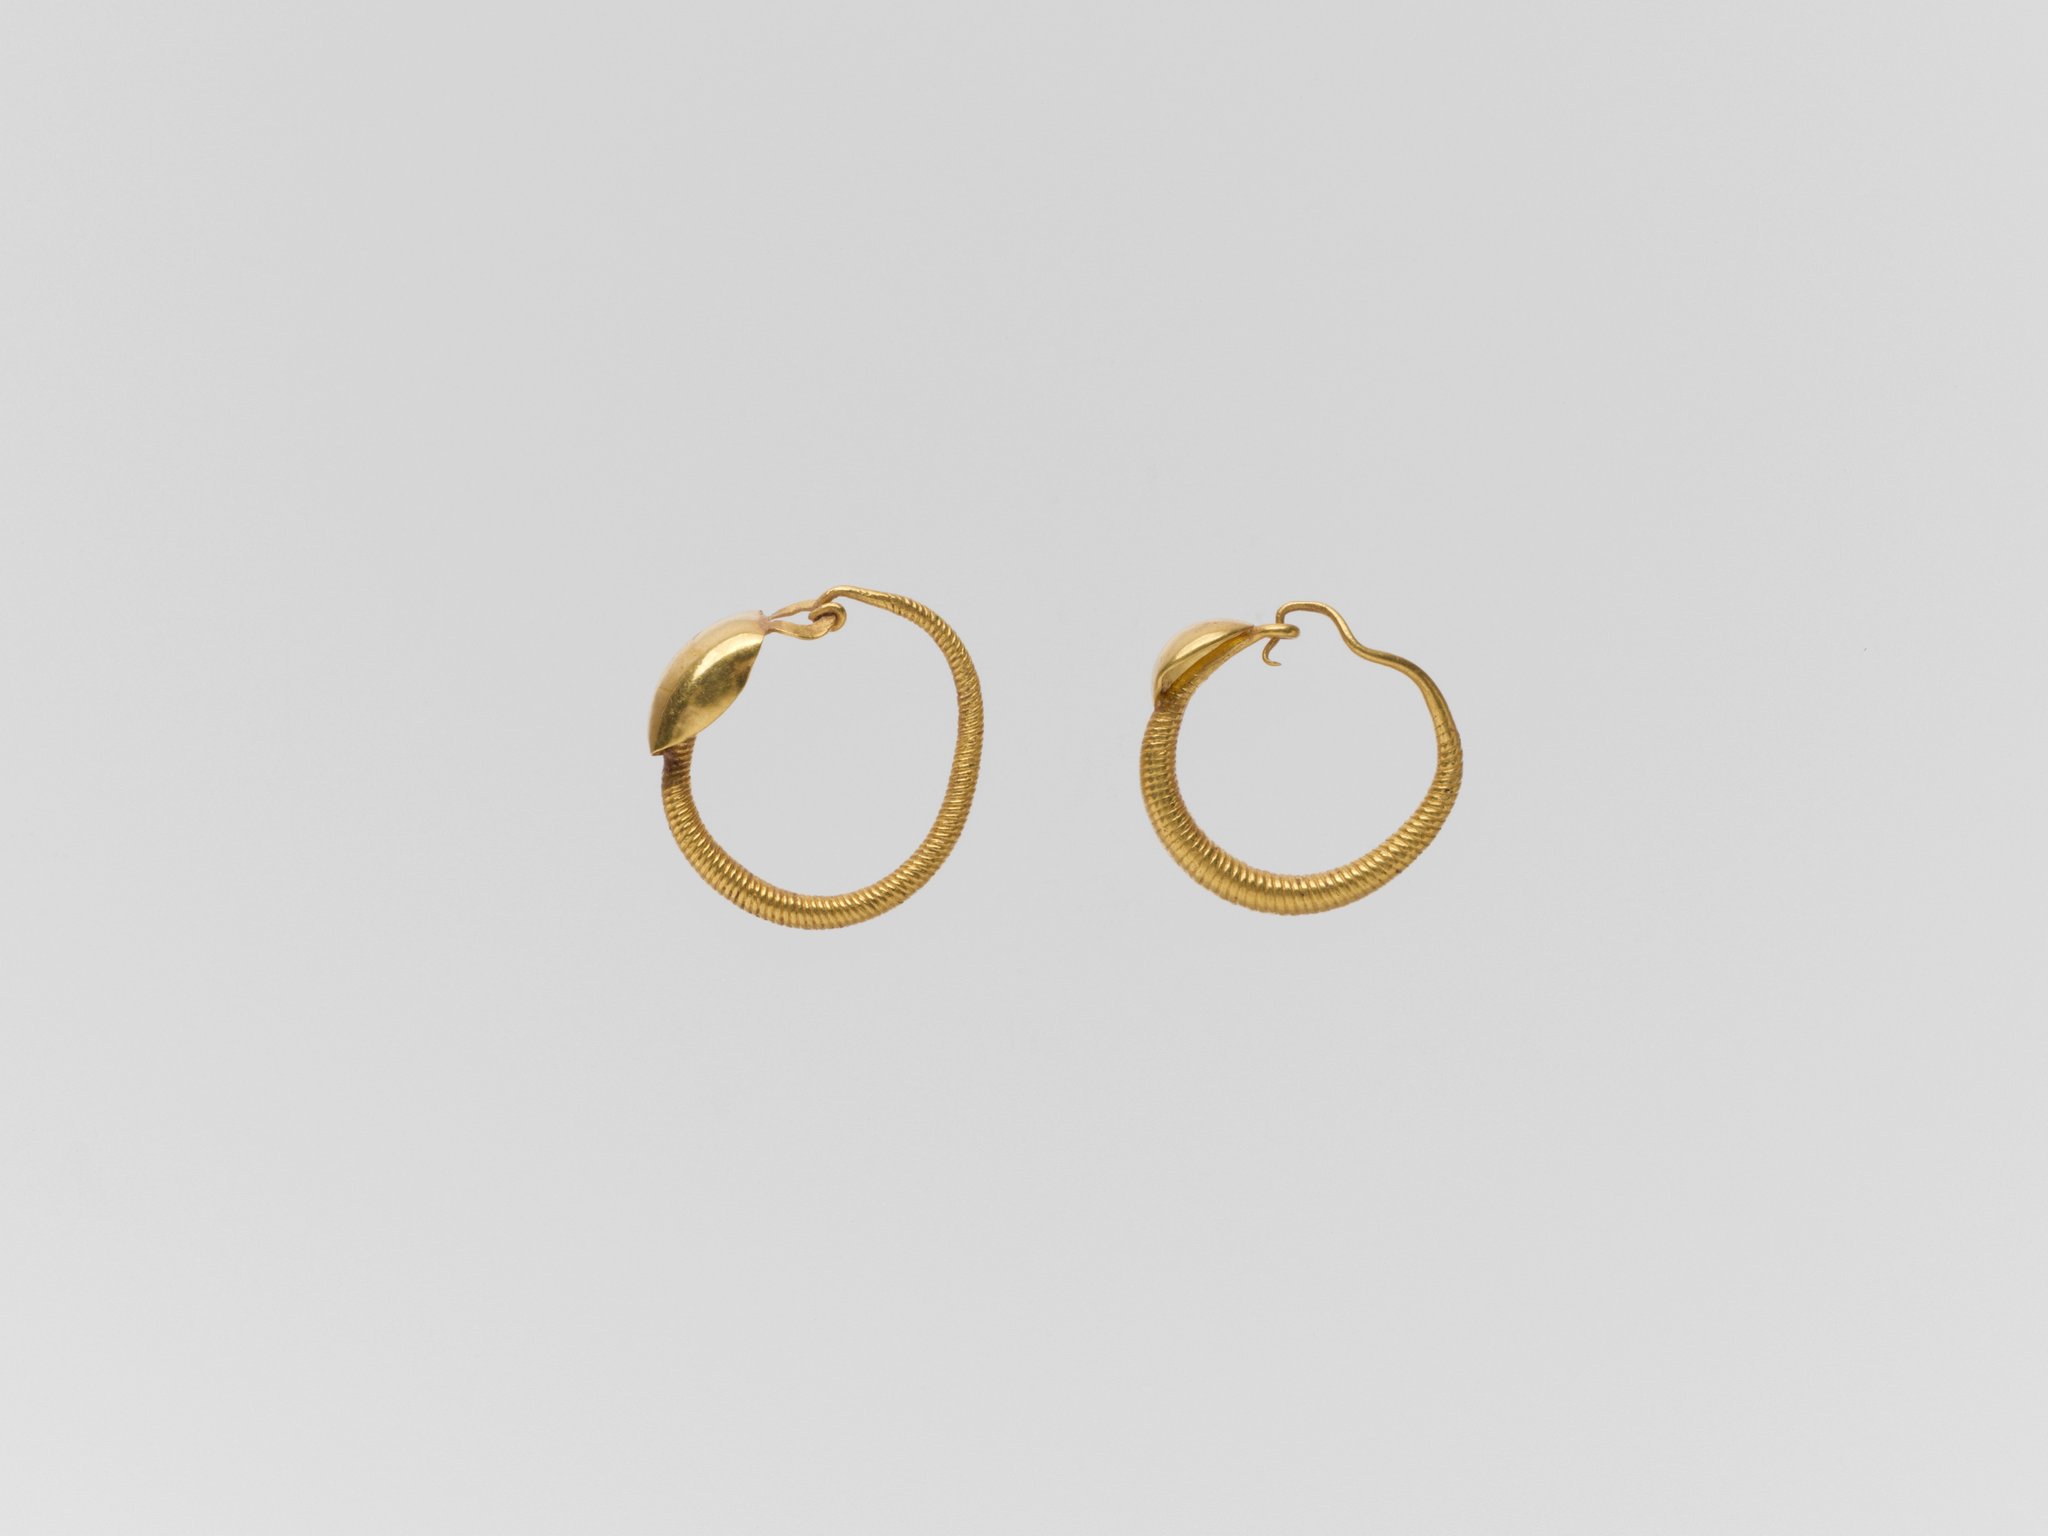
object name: earring with plain loop and disc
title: Gold earring with convex disc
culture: roman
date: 101-300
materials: gold